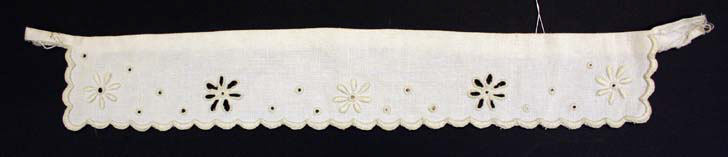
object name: collar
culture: american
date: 1700-1941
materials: linen